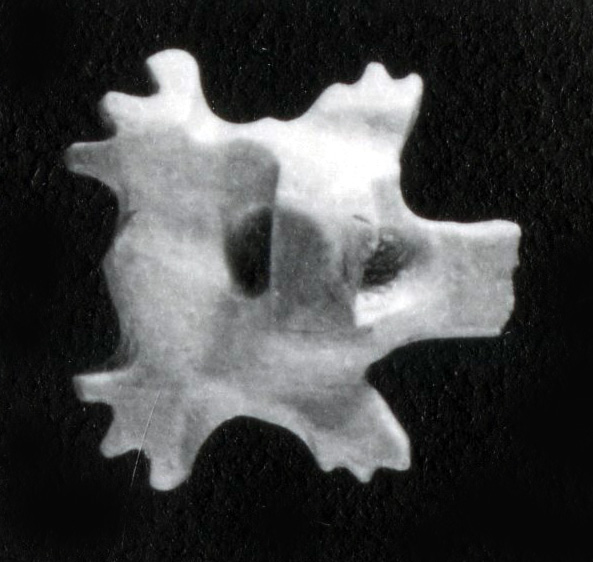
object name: amulet, turtle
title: Turtle amulet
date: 2110-2030 BCE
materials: ivory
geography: egypt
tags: turtles